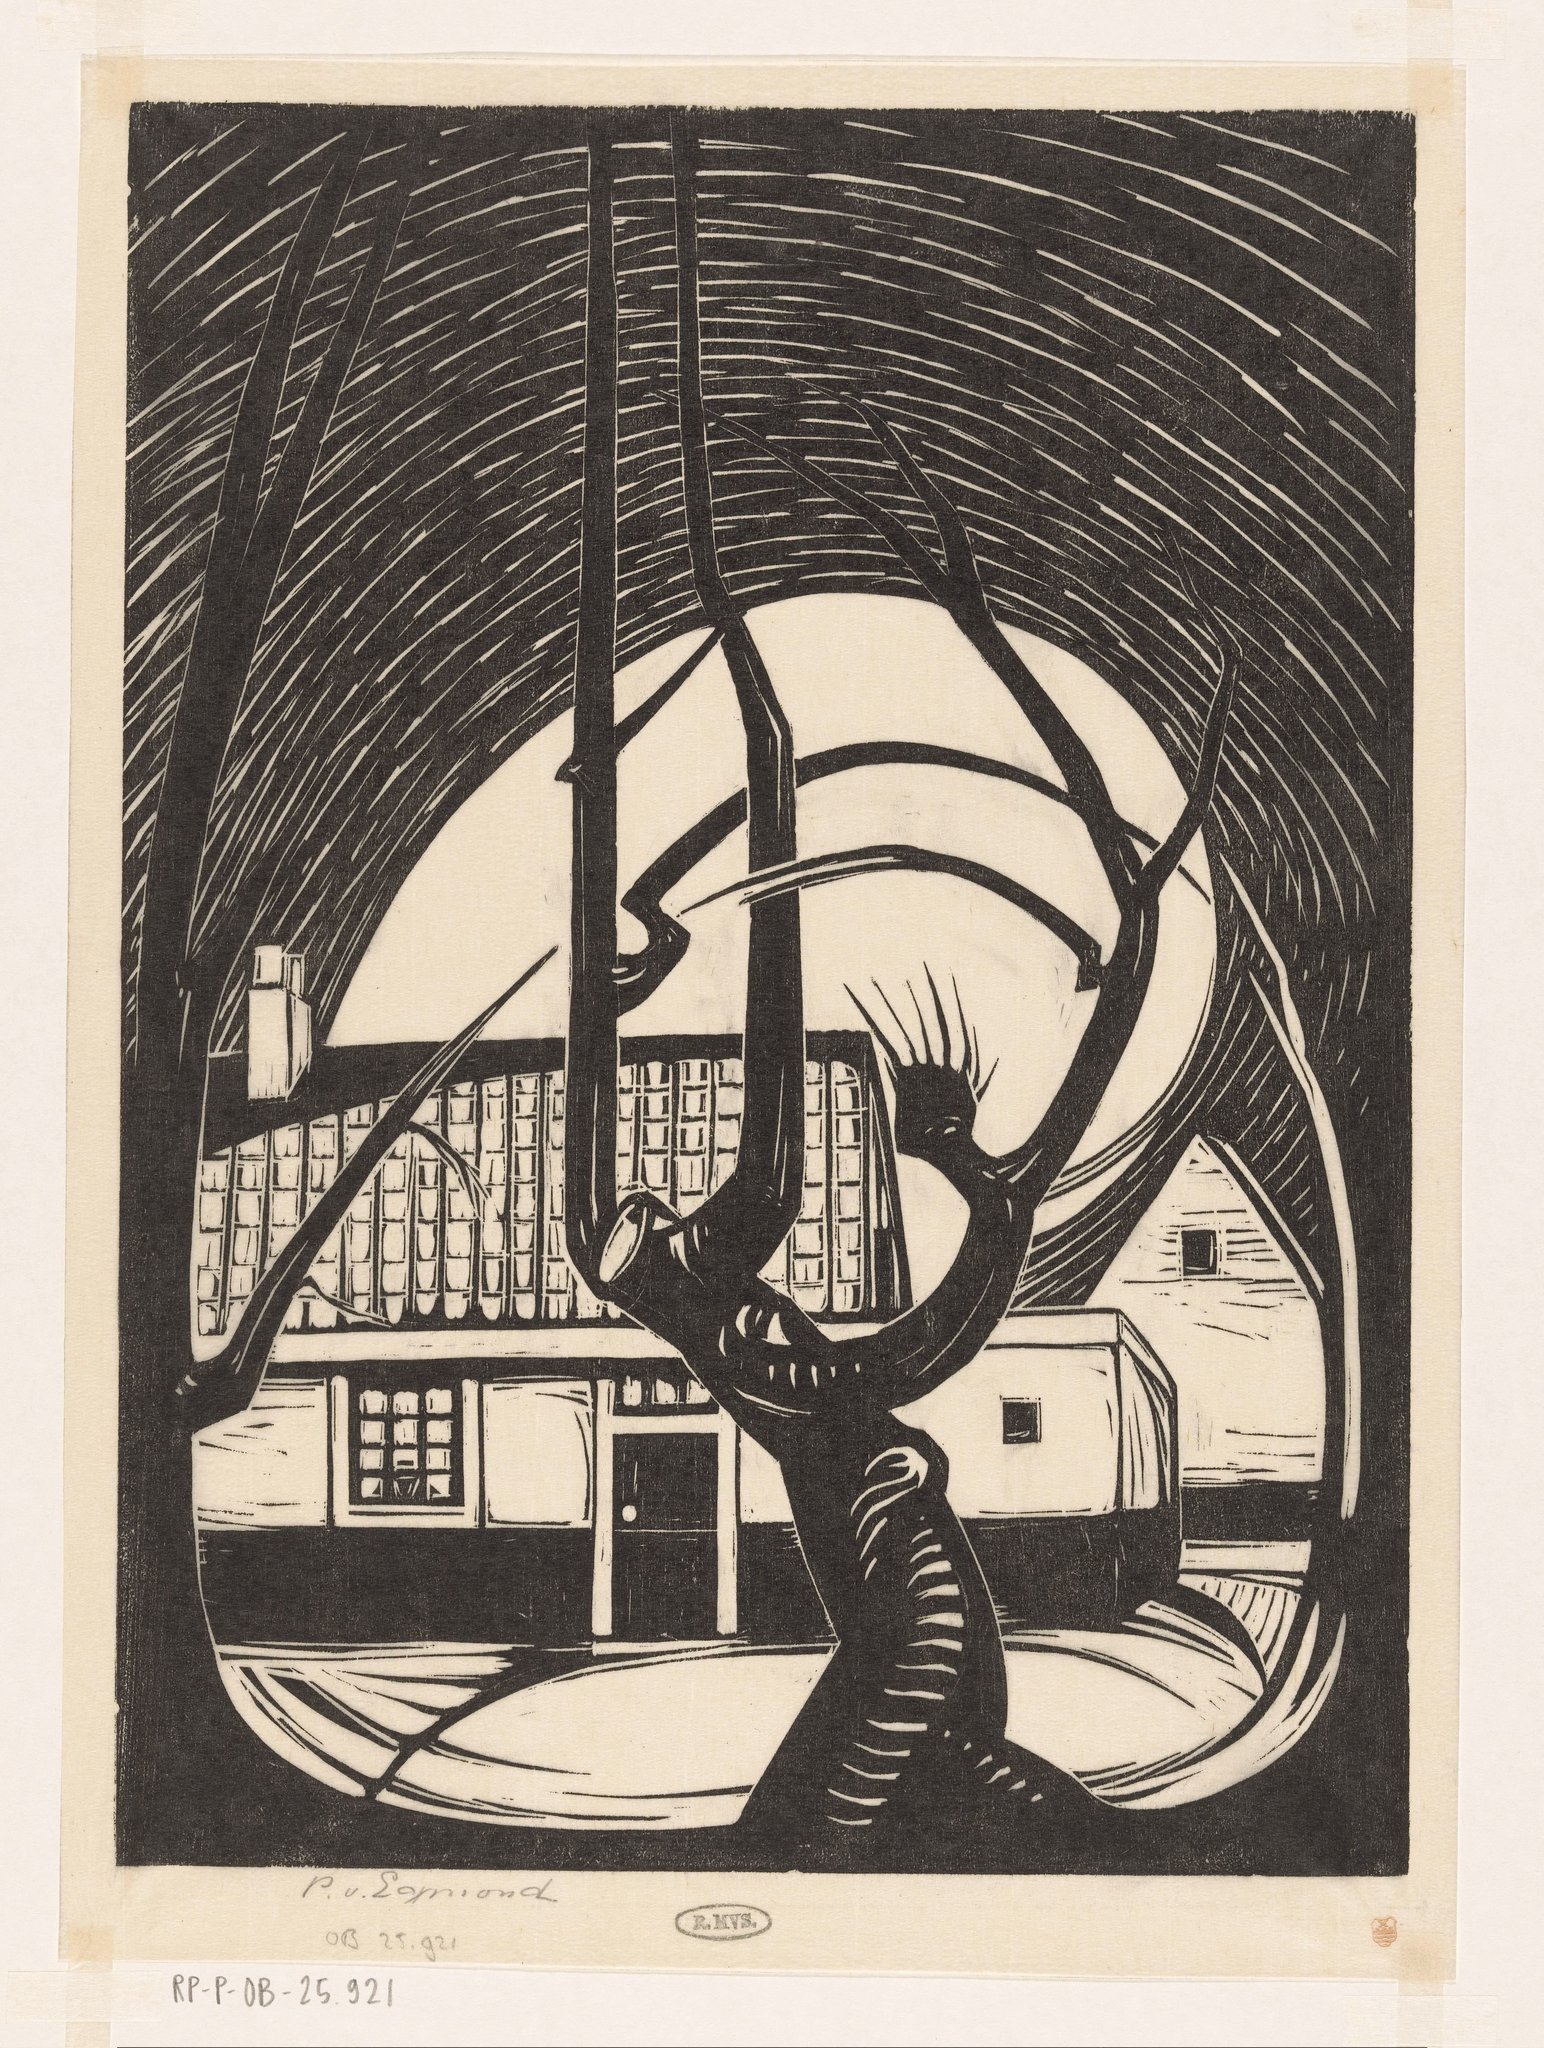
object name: print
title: Wilg voor een huis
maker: piet egmond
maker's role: print maker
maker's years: 1864-1908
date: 1874-1908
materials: paper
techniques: woodcut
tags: trees: willow, country-house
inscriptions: collector's mark: Lugt 2228, collector's mark: Lugt 2760